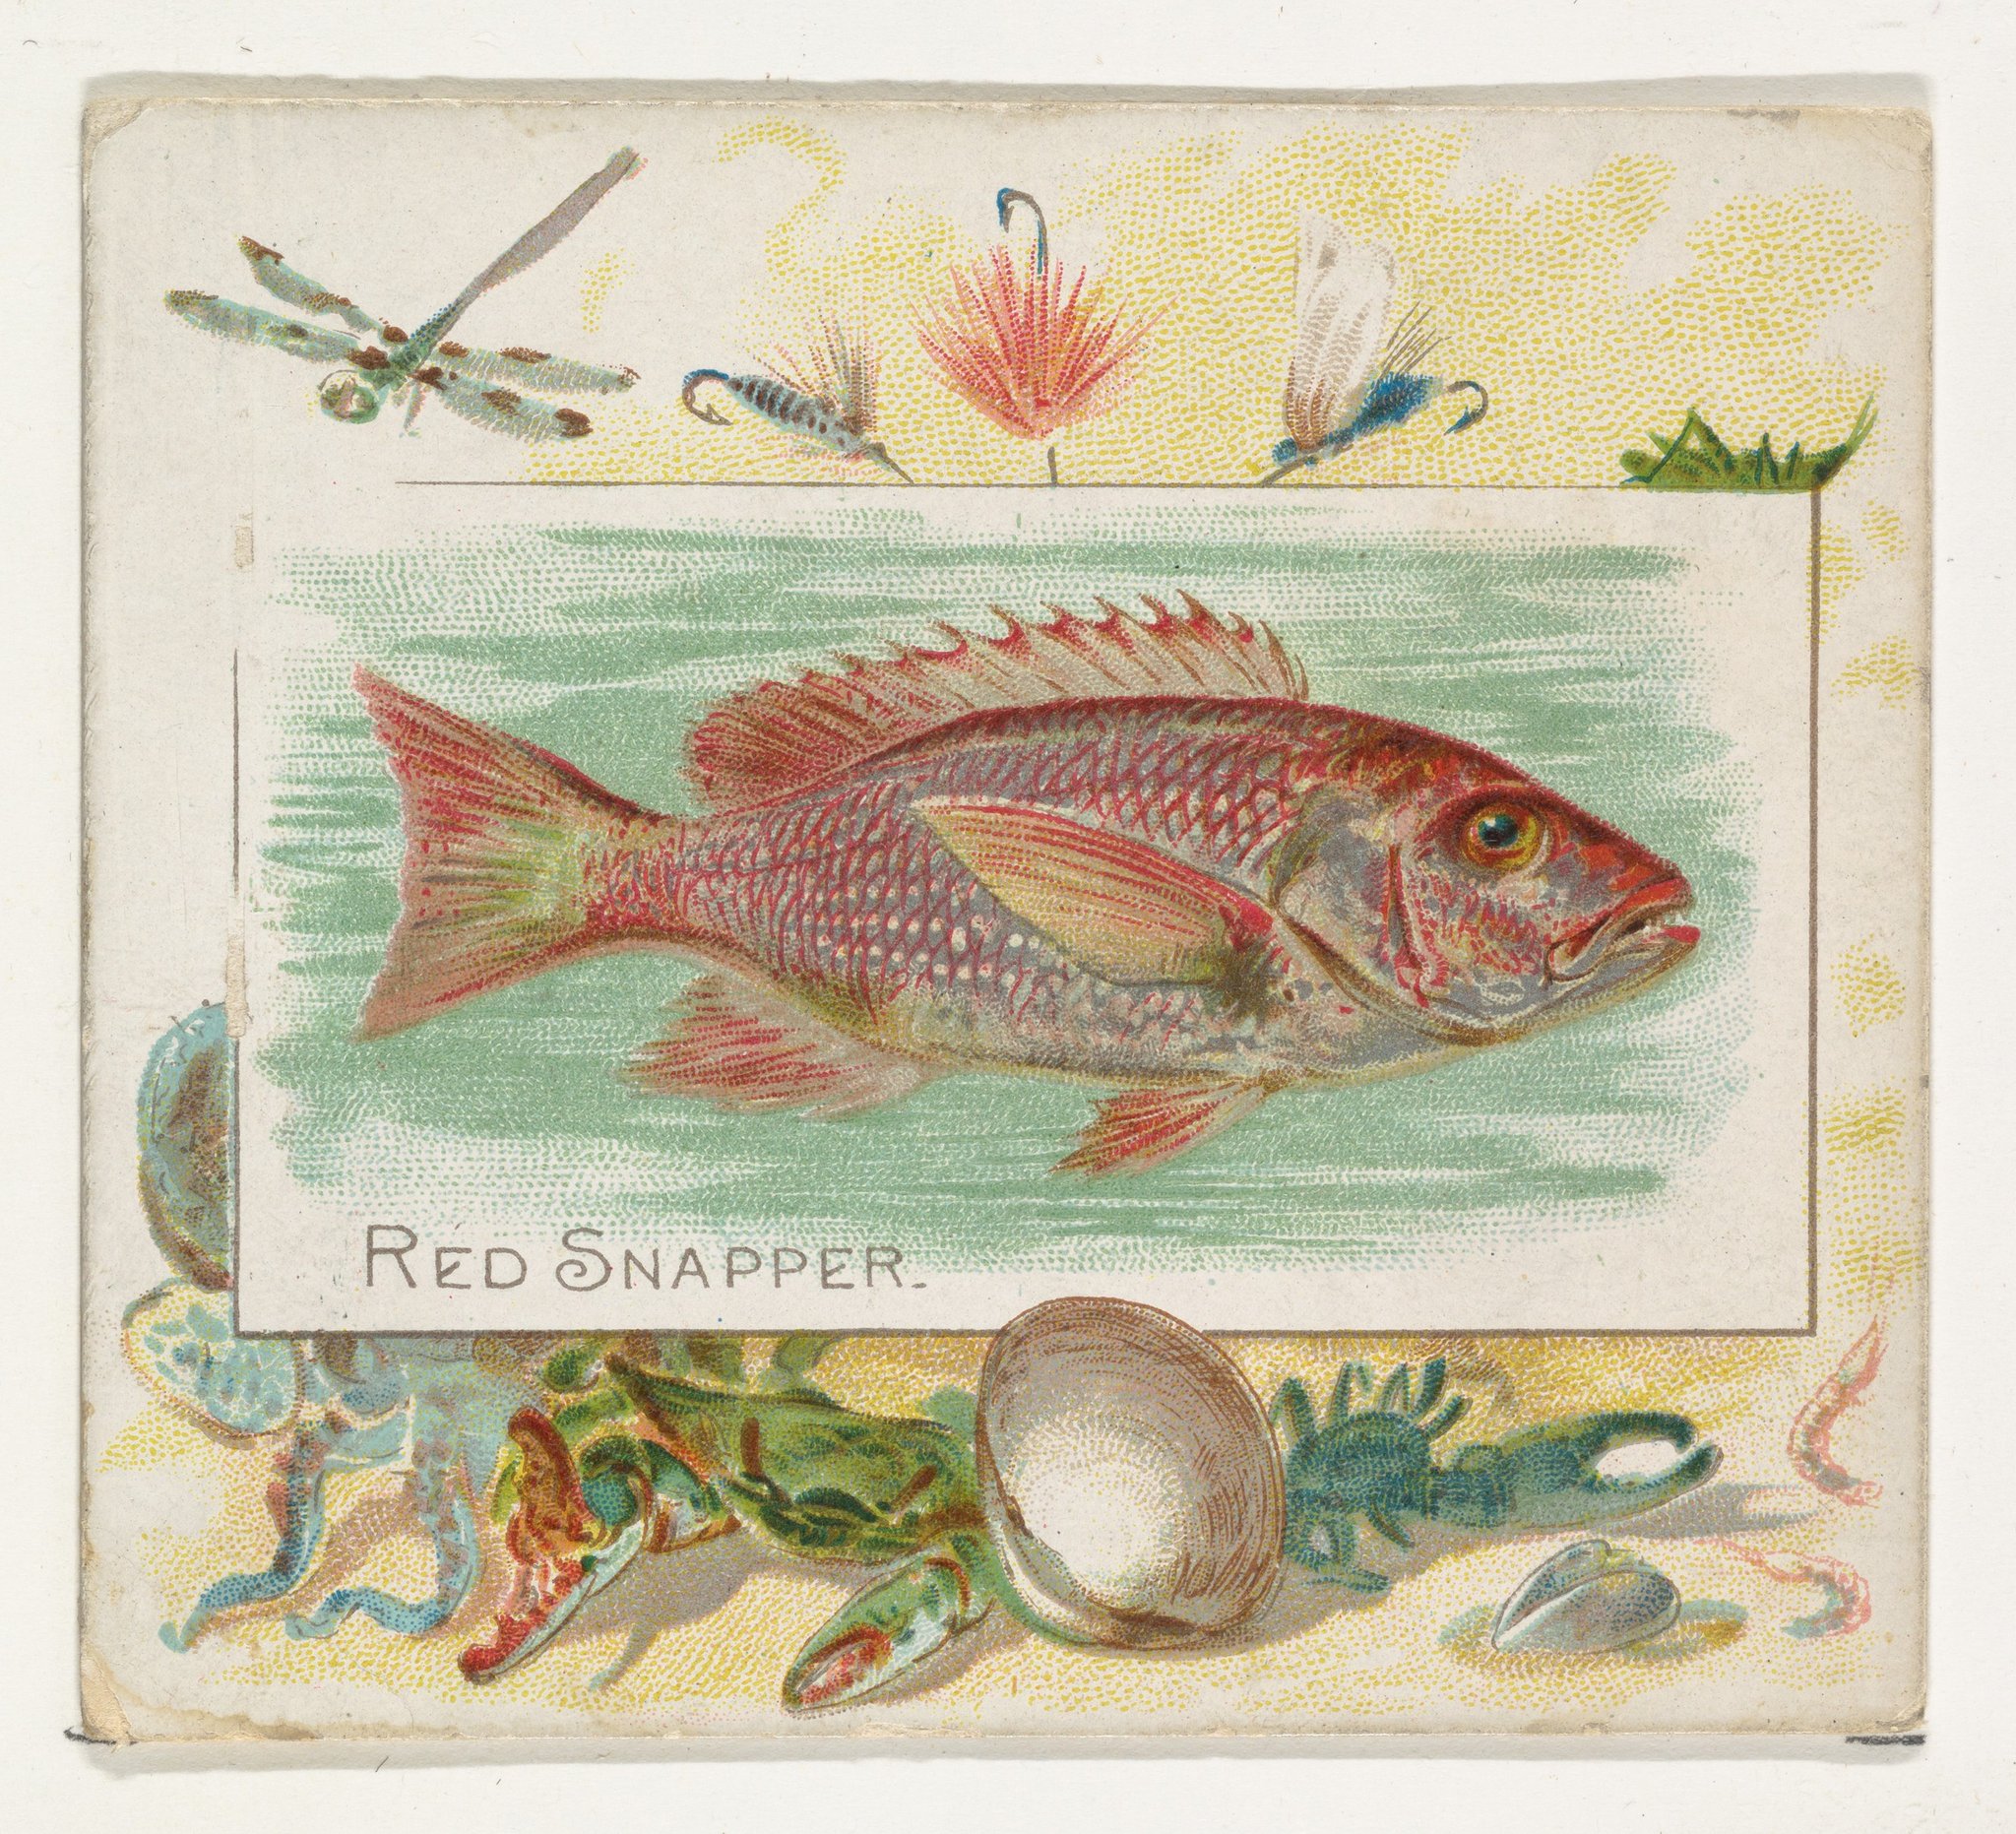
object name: print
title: Red Snapper, from Fish from American Waters series (N39) for Allen & Ginter Cigarettes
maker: allen & ginter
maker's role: publisher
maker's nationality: american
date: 1889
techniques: color lithograph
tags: fish